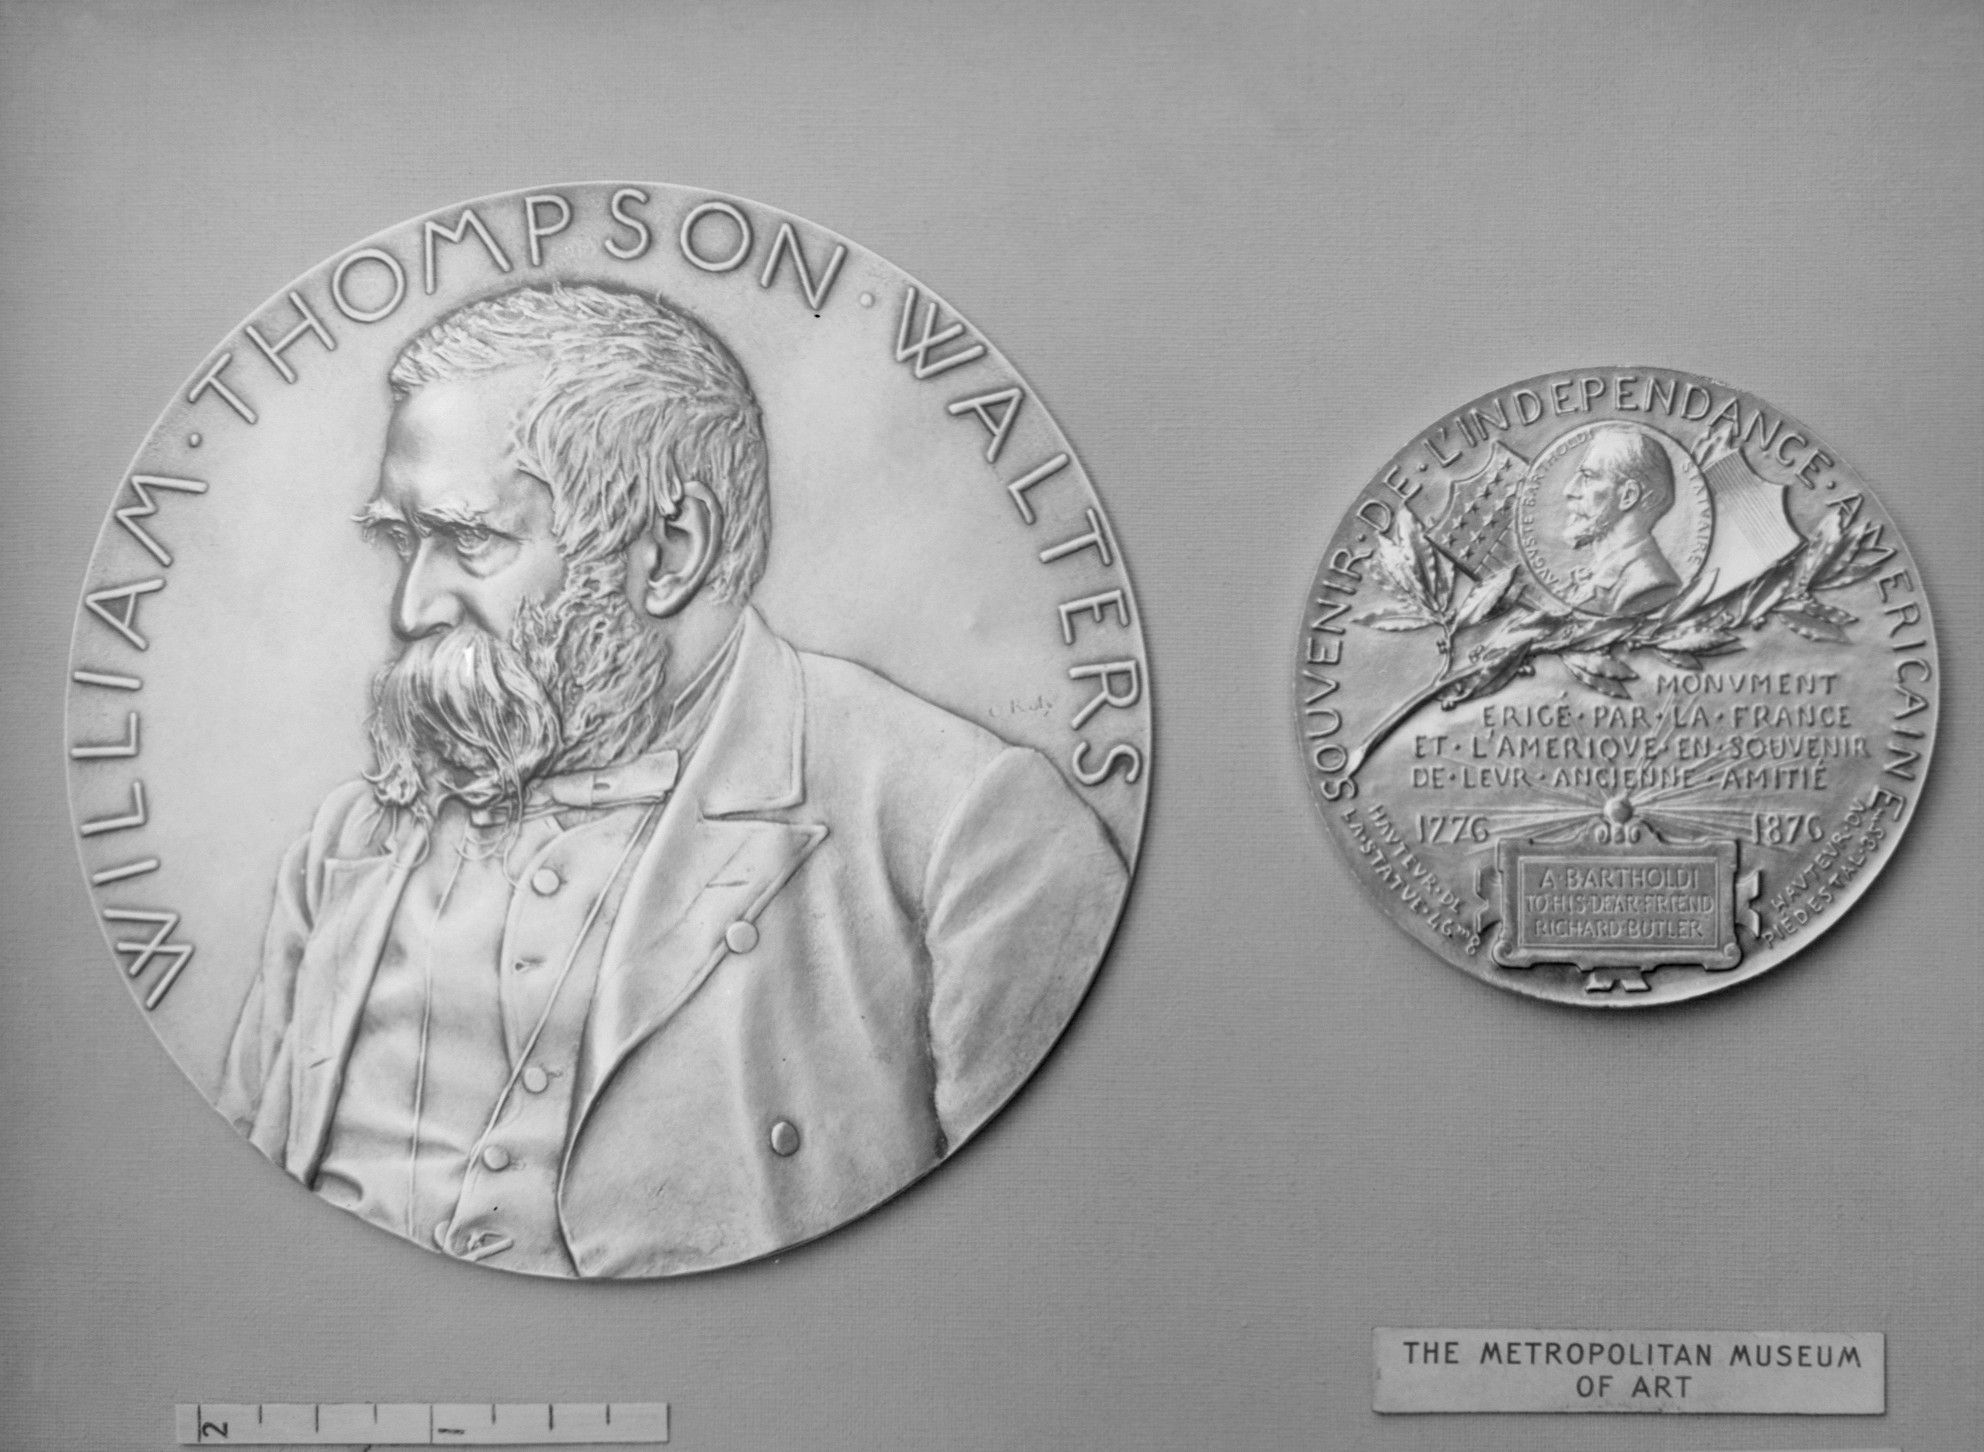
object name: medallion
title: Portrait of William Thompson Walters (1819–1894)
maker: louis-oscar roty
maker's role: artist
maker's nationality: french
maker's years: 1846-1911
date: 1894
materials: silver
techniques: casting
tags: men,portraits,profiles